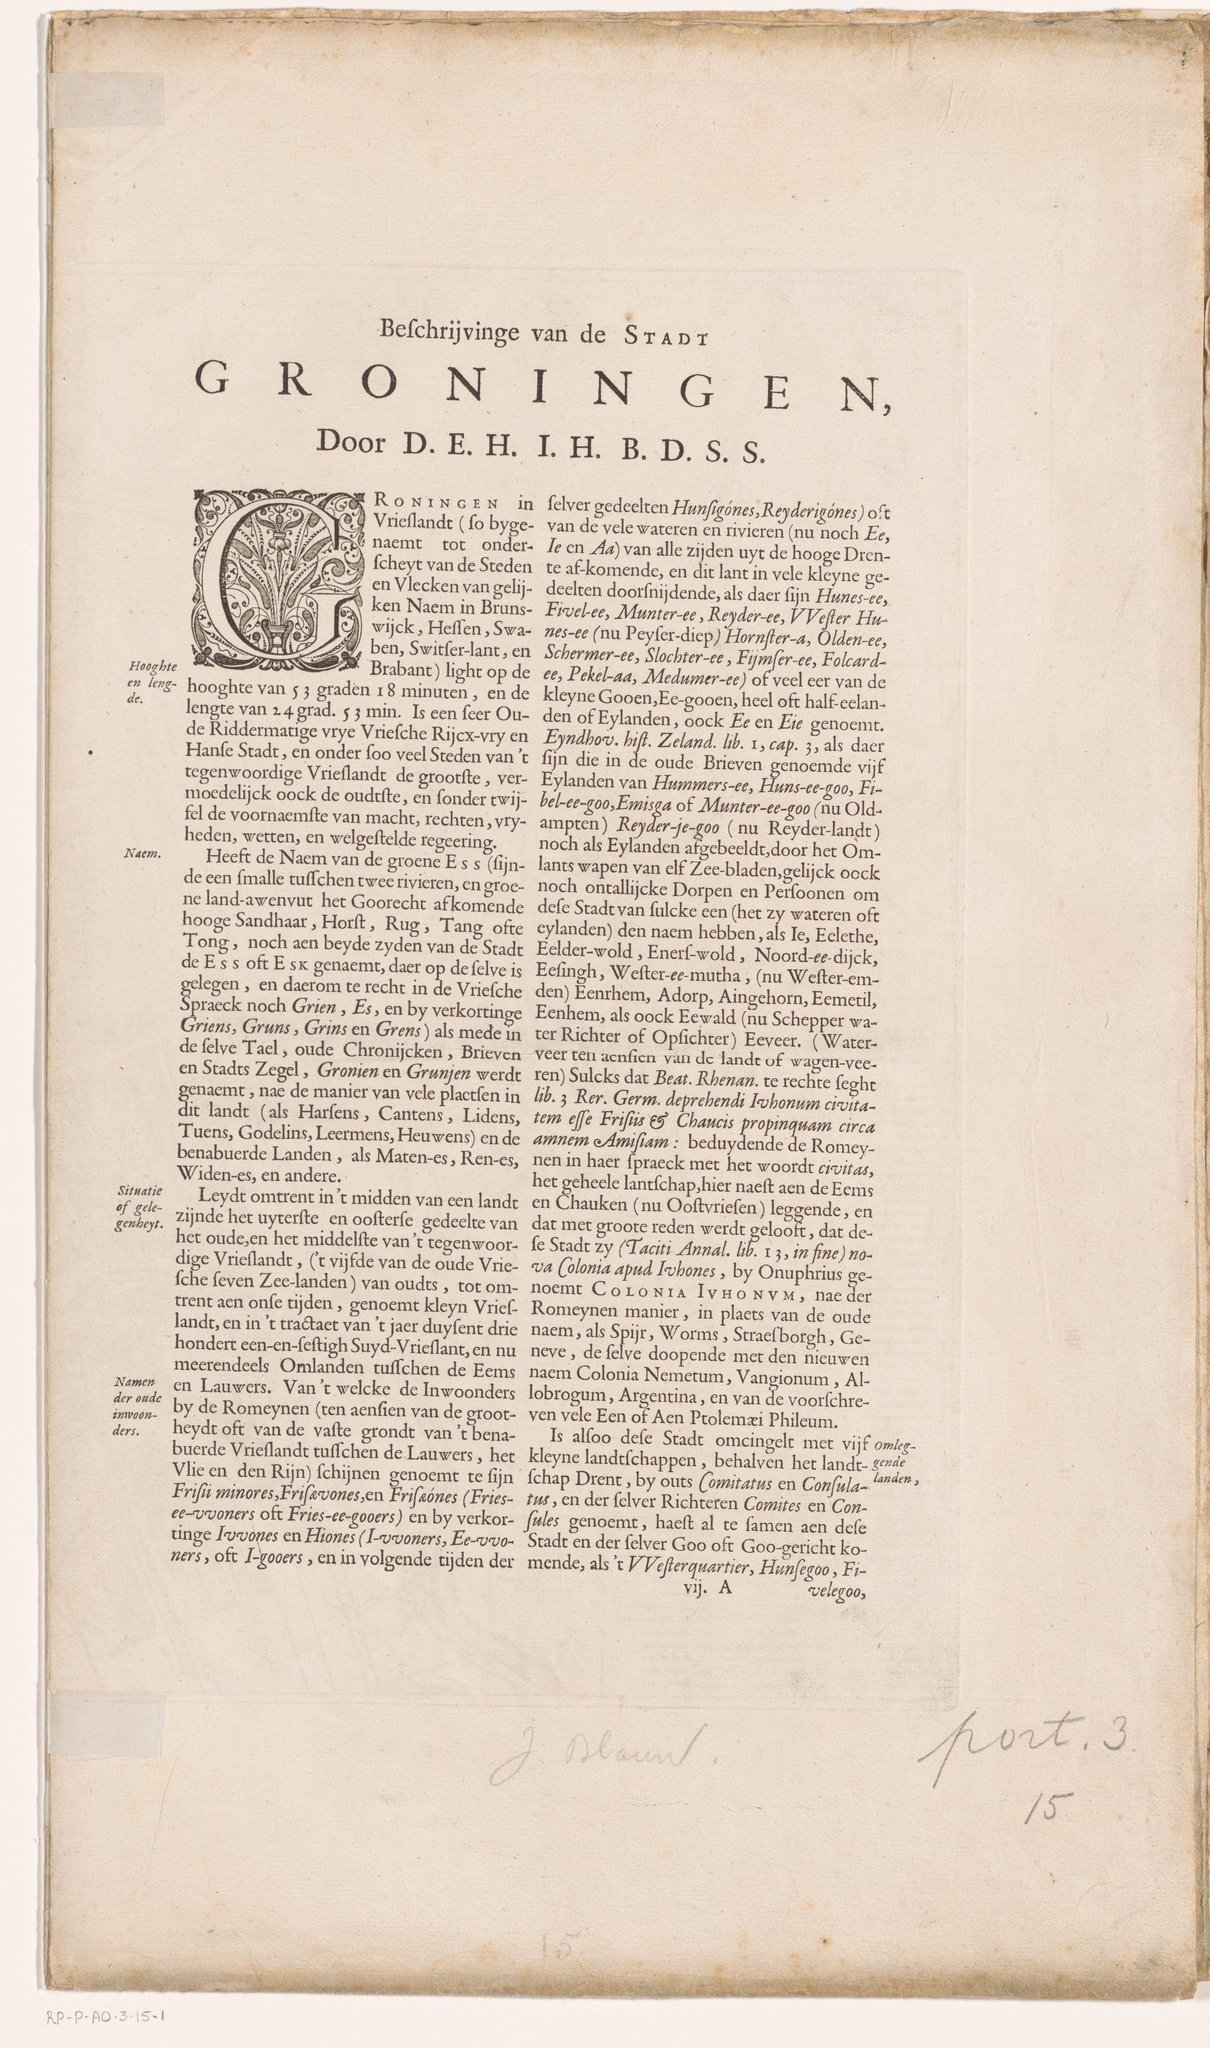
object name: area plan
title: Groeninga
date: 1652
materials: paper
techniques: engraving, etching, letterpress printing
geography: amsterdam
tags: coat of arms (as symbol of the state, etc.), maps of cities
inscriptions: collector's mark: Lugt 2228, collector's mark: Lugt 195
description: Linksboven schaalstok: Scala van 50 roeden. Linksonder legenda. Rechtsonder cartouche met het wapen van de stad Groningen, titel en opdracht. Op verso Nederlandse tekst.